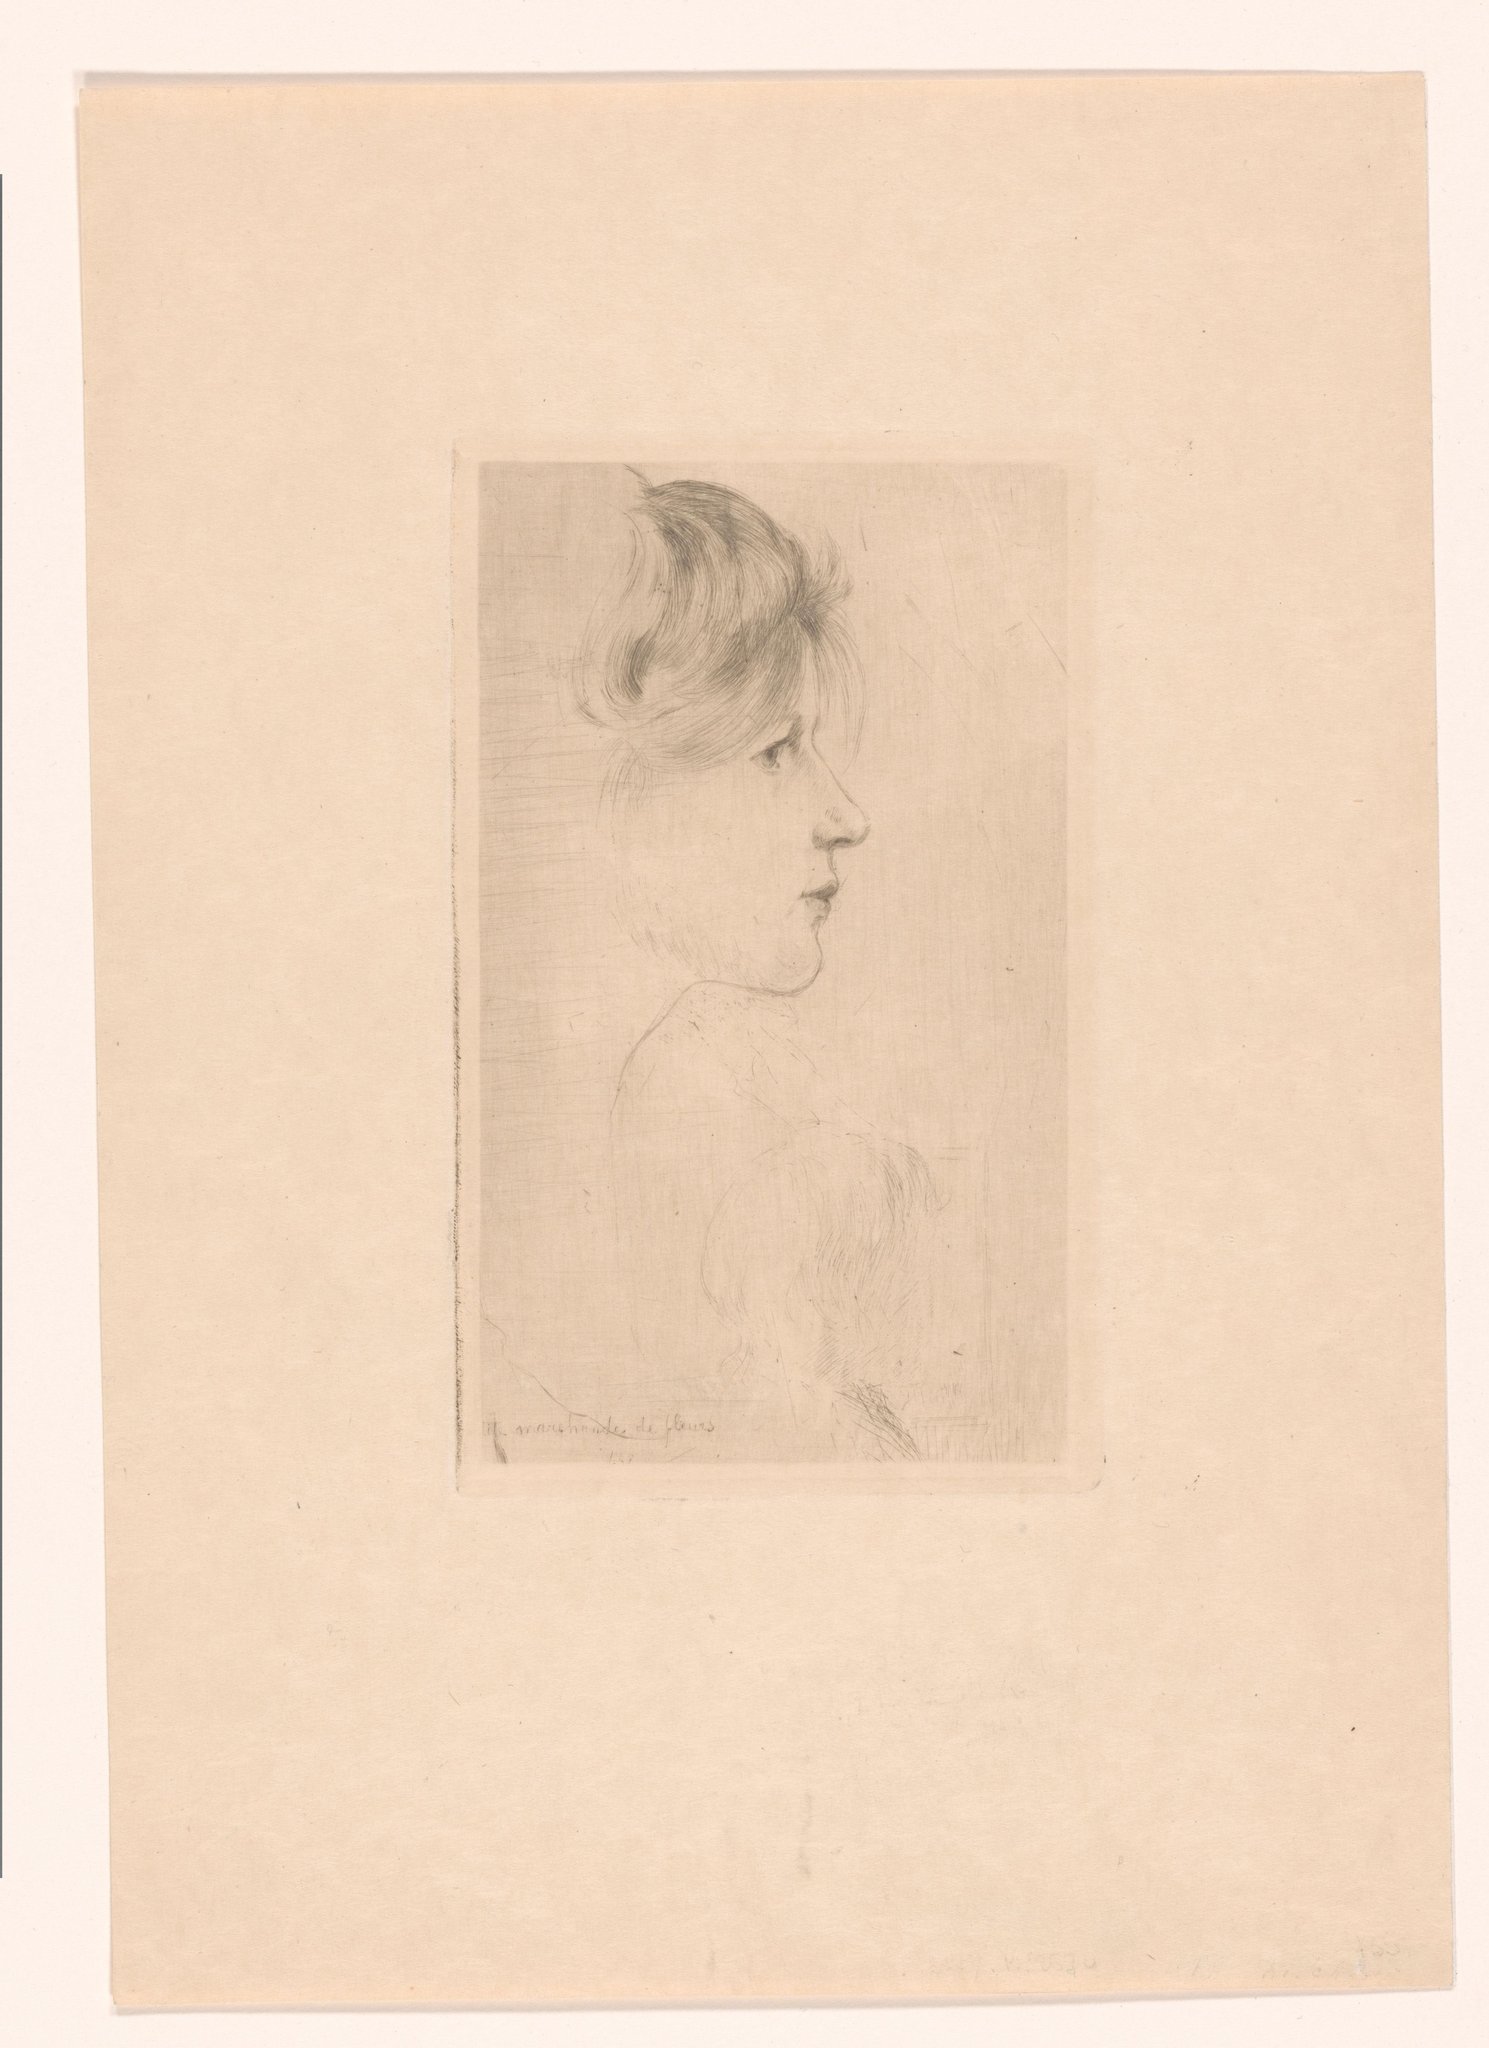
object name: print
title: Petite marchande de fleurs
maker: philip zilcken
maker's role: draughtsman, painter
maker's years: 1857-1930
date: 1870-1918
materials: paper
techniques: drypoint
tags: adolescent, young woman, maiden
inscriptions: collector's mark: Lugt 2228, collector's mark: Lugt 2760